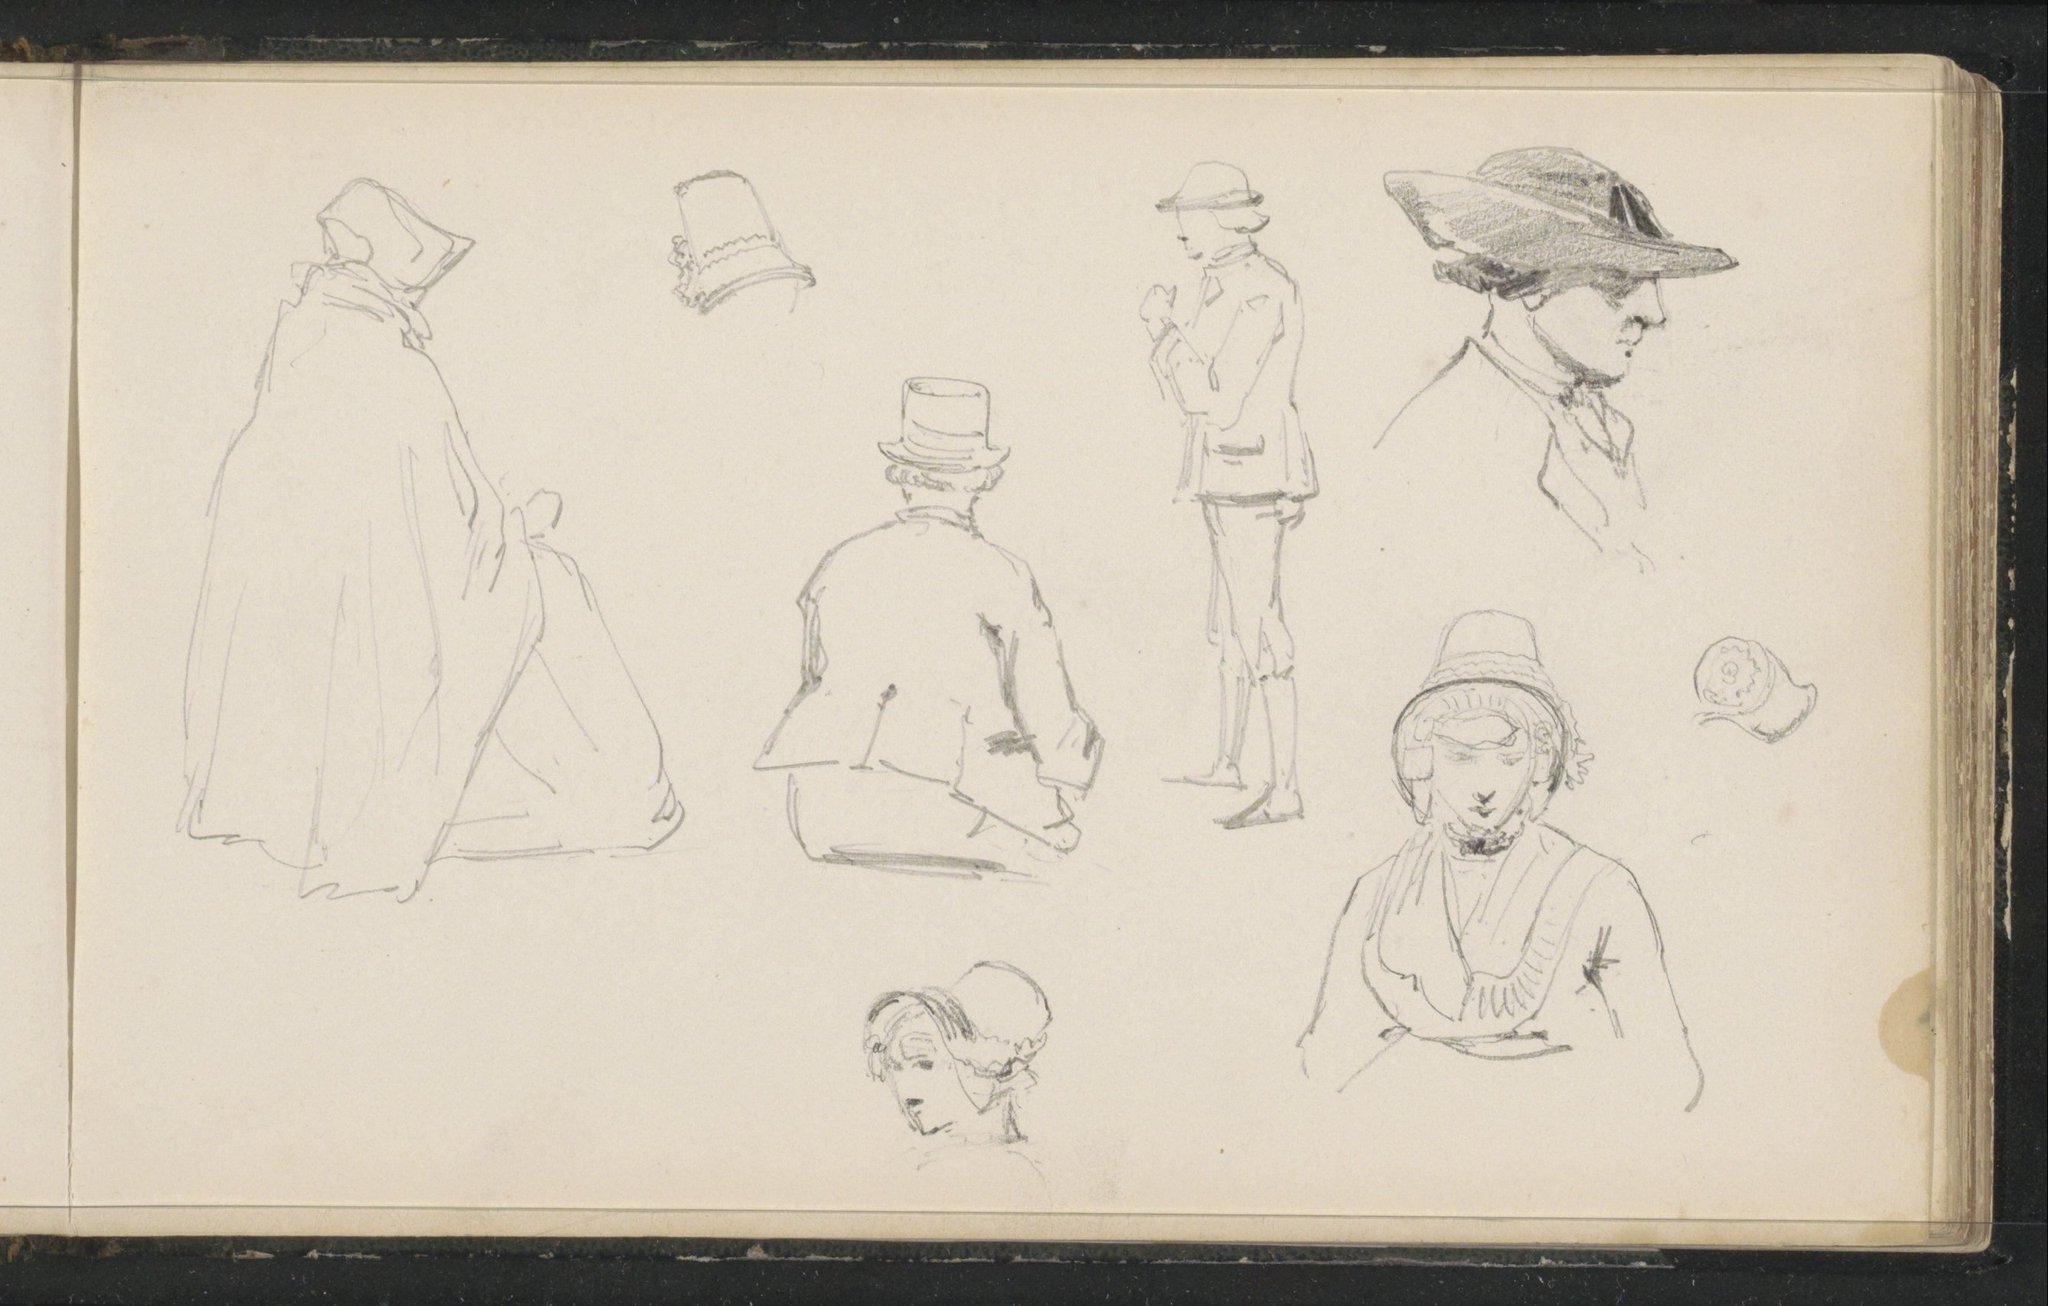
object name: sketchbook leaf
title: Figuren in Zeeuwse kostuums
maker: cornelis springer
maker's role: draughtsman, painter, print maker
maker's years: 1817-1891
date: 1856-1861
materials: paper, pencil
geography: zeeland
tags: adult woman, adult man, clothes, costume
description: Mannen en vrouwen in Zeeuwse kostuums. Blad 8 uit een schetsboek met 44 bladen vervaardigd in Zeeland en Utrecht.